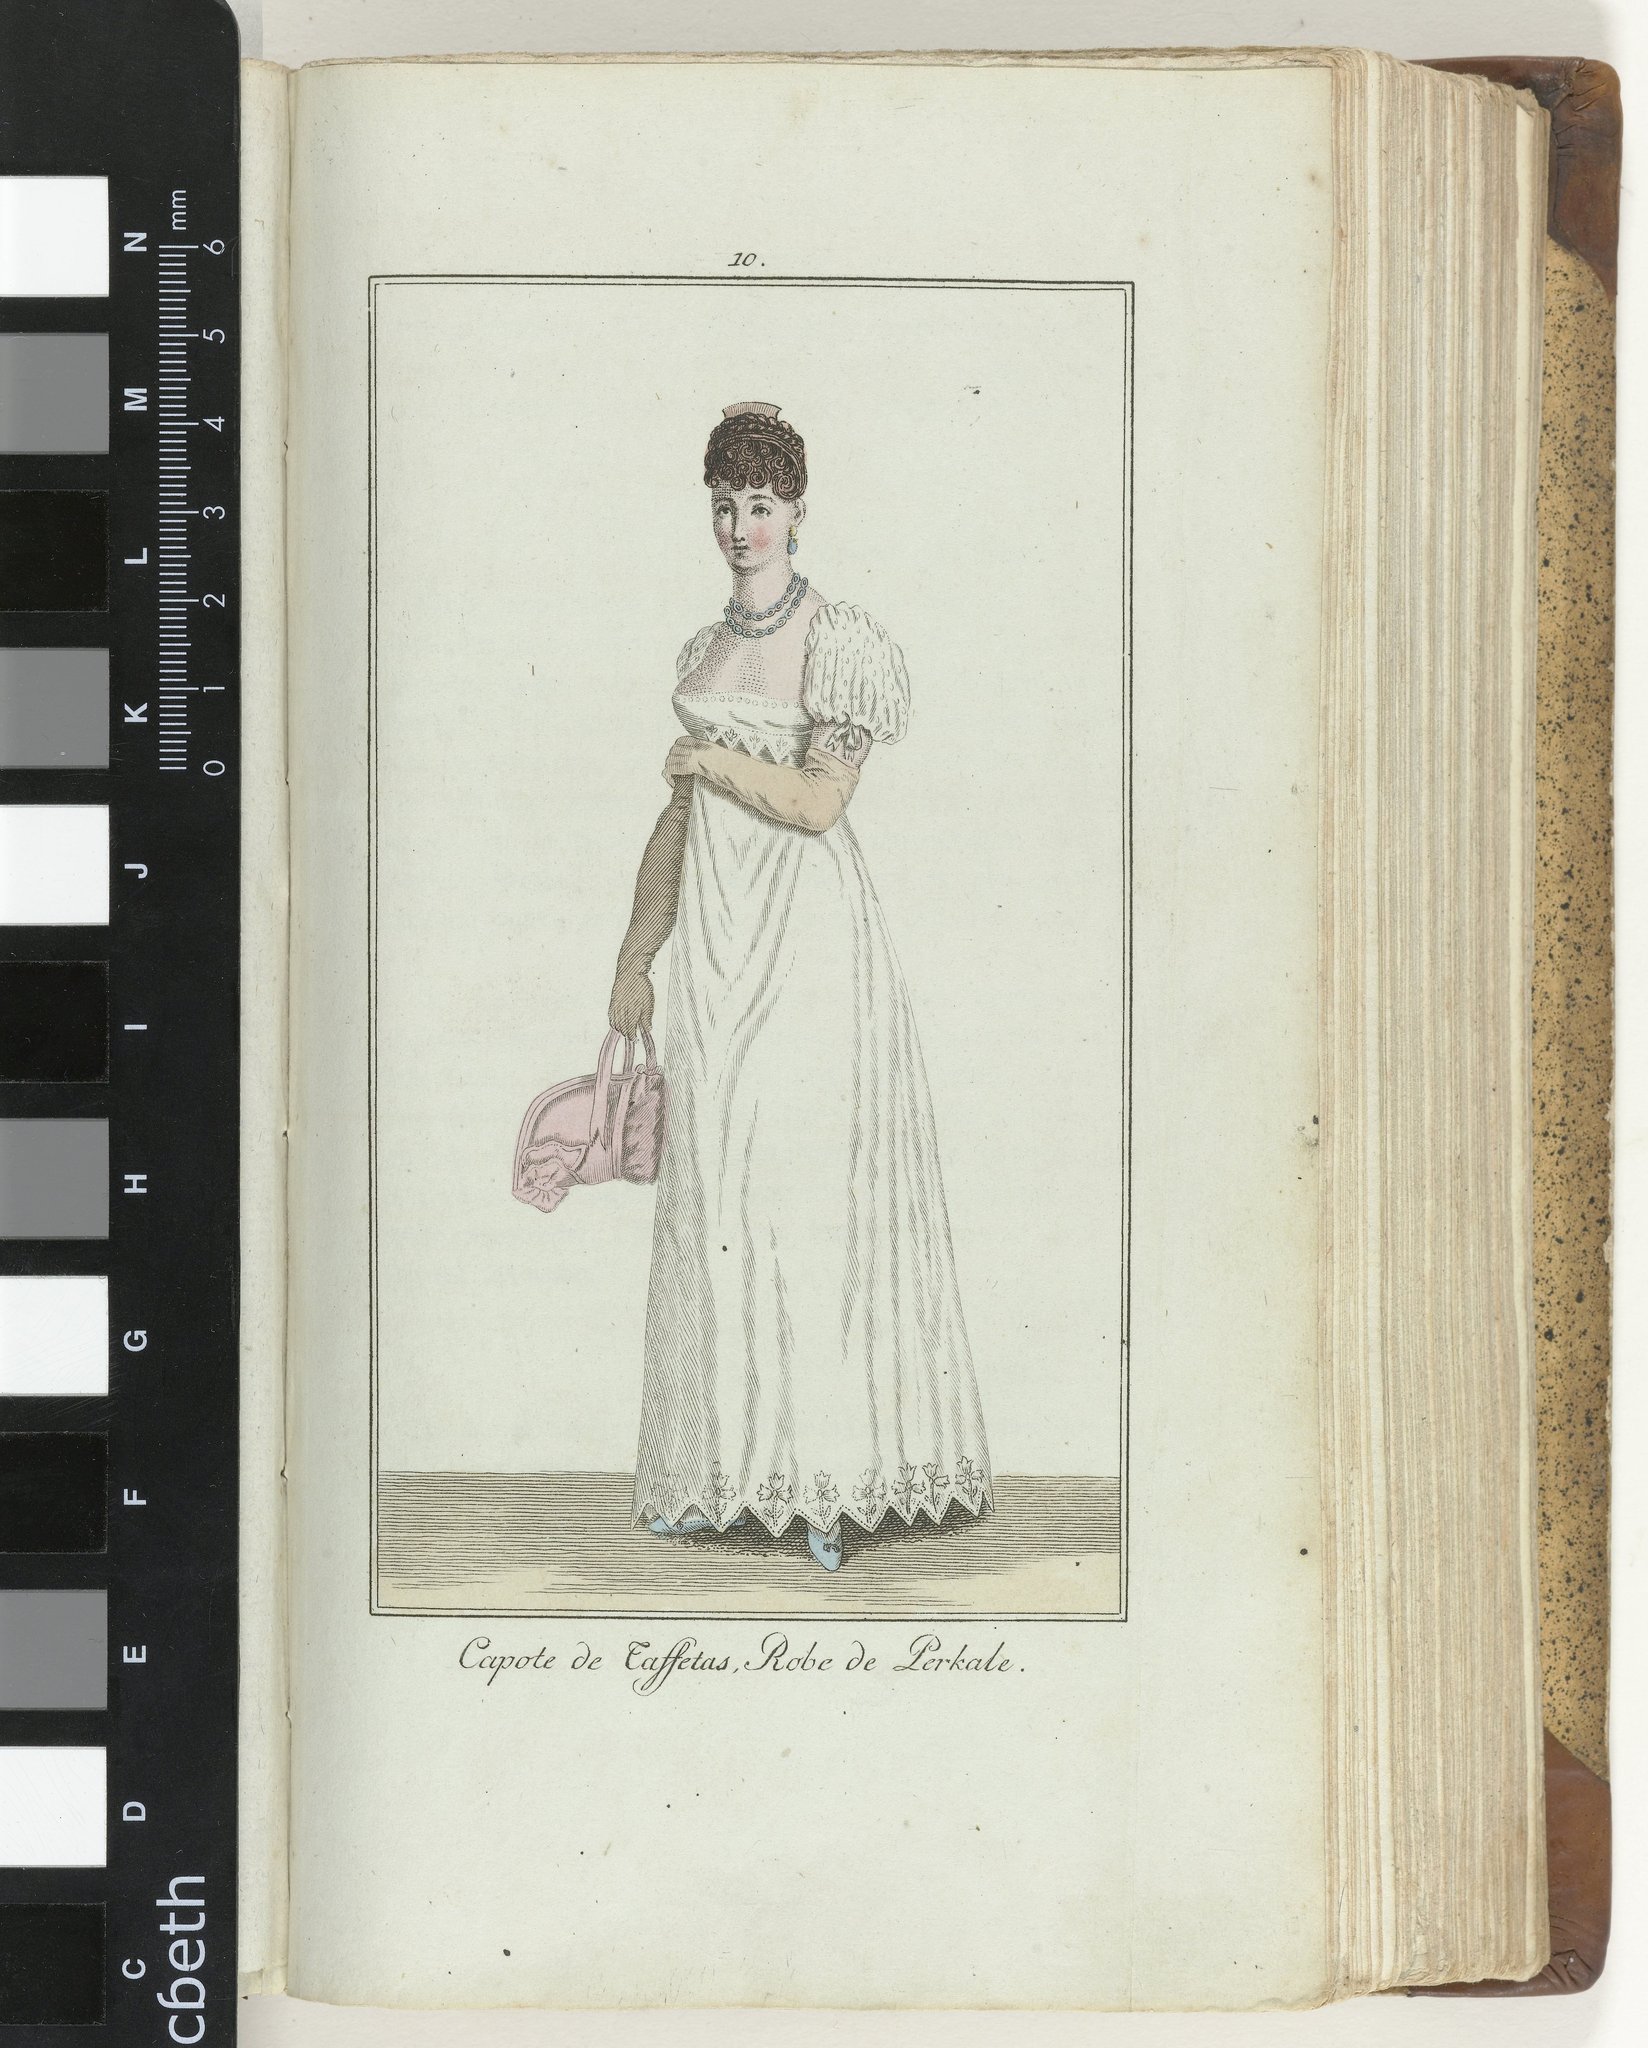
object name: fashion print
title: Elegantia, of tijdschrift van mode, luxe en smaak voor dames, Mei 1807, No. 10: Capote de Taffetas.Robe de Perkale.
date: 1807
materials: paper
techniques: engraving, hand coloring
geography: amsterdam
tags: head-gear (capote) (+ women's clothes), gloves, mittens (long gloves) (+ women's clothes), embroidery (ornamentation) (+ women's clothes), fashion plates, shoes, sandals (+ women's clothes), dress, gown (+ women's clothes), necklace (+ women's clothes)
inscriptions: caption: ‘Capote de Taffetas, Robe de Perkale’